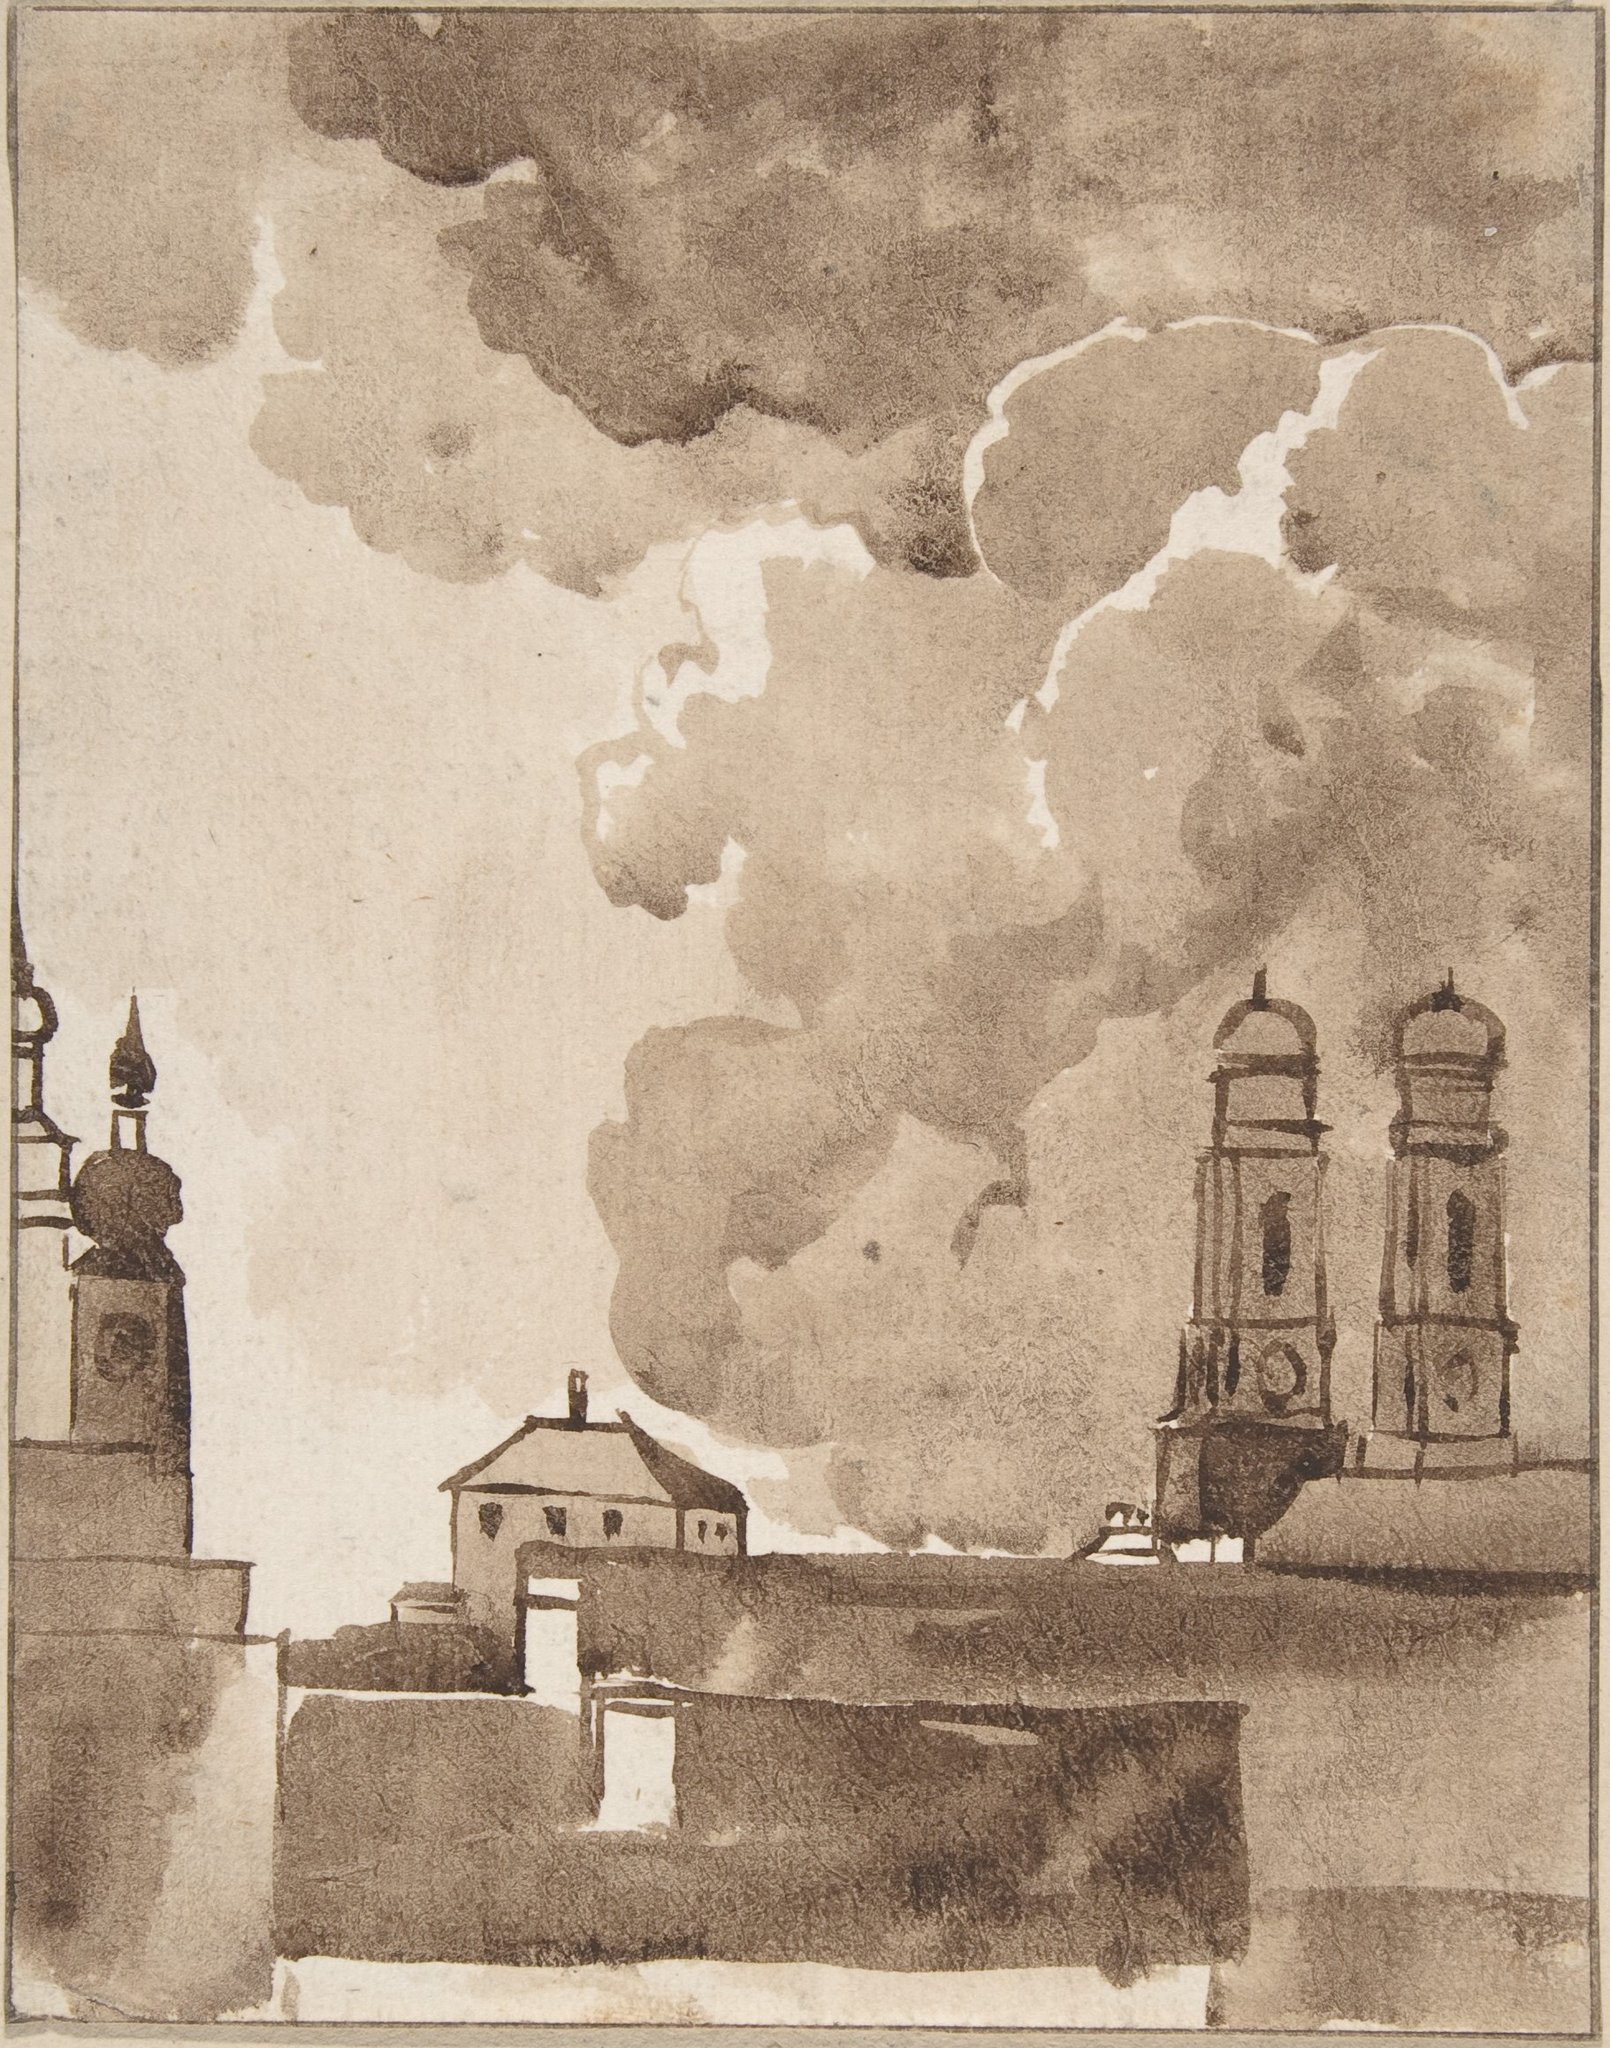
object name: drawing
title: View of Munich with Marienkirche on right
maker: franz kobell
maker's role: artist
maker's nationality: german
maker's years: 1749-1822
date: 1767-1833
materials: watercolor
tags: buildings,churches